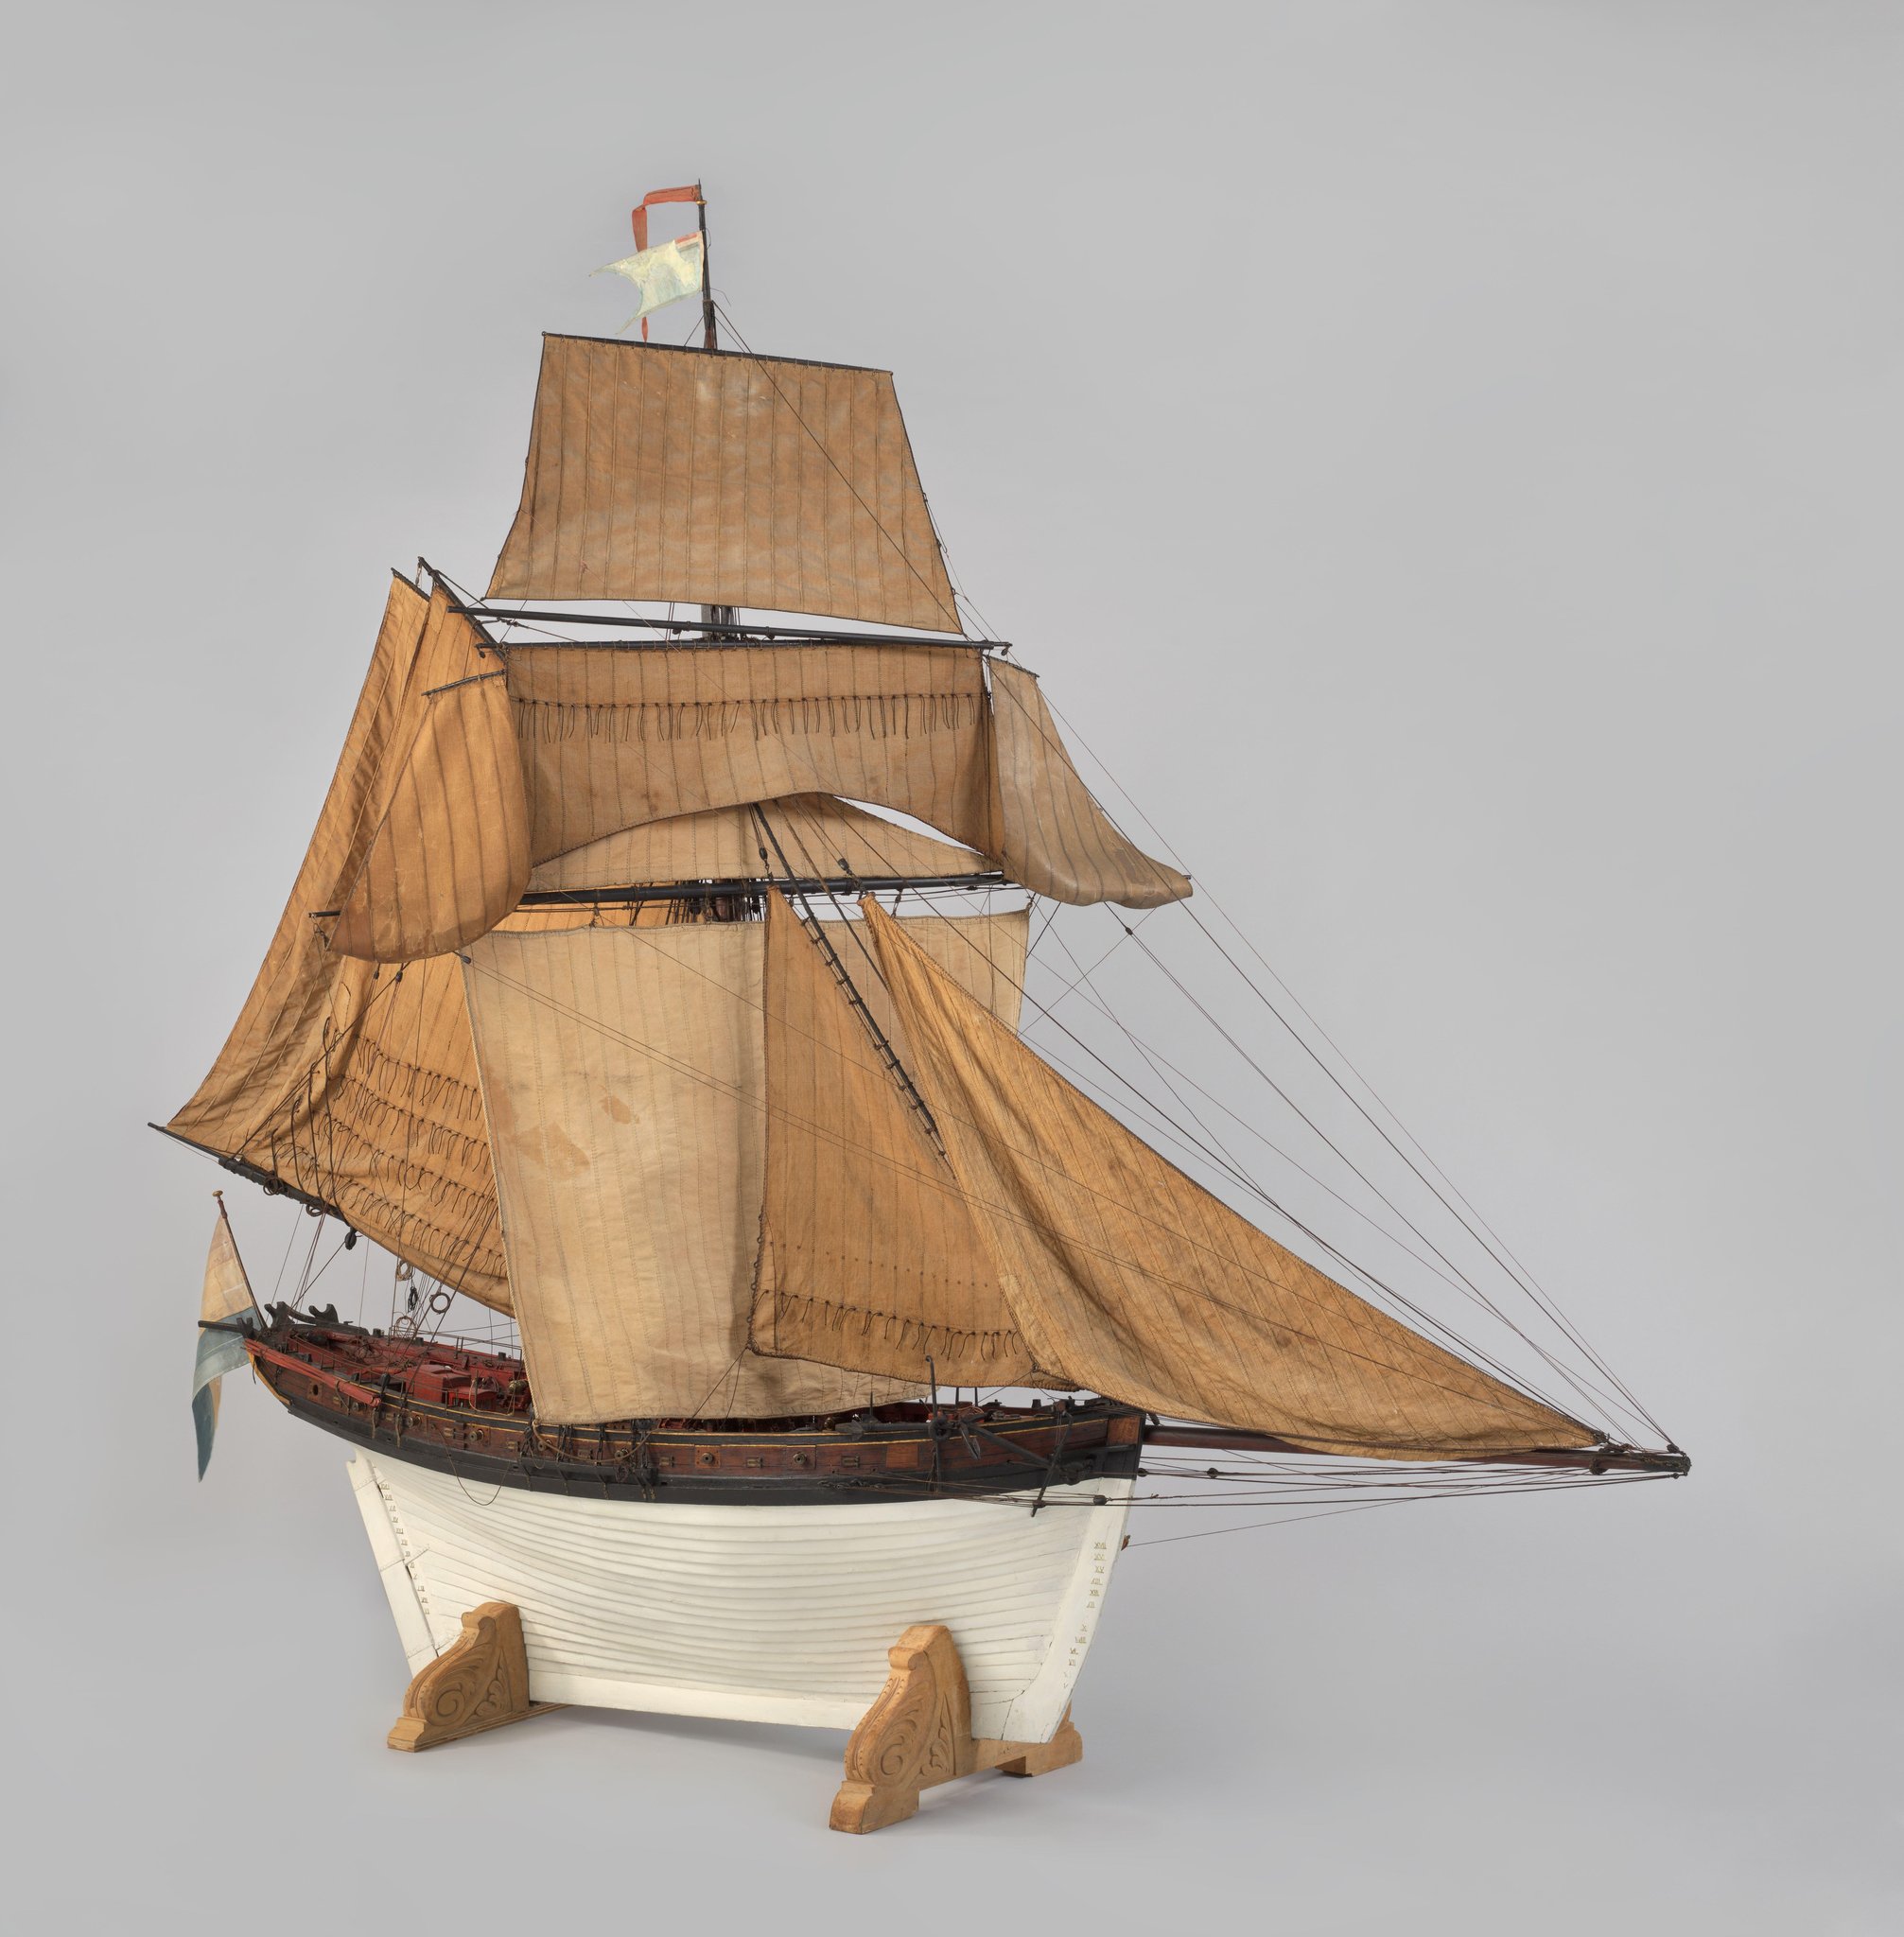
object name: fully rigged model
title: Model of an 18-Gun Cutter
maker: Anonymous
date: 1775-1805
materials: brass, glass, iron, leather, fiber, textile, wood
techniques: polychromy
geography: netherlands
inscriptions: inscription, on the taffrail: ‘VLIEG’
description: Dit model behoorde in 1807 tot de privé-collectie van J.P. Asmus en stond in de modellenzaal op de Marinewerf te Amsterdam. Volgens de beschrijving had het toen nog een sloepje in de davits aan het hek hangen, en een zonnetent over geheel het dek gespannen. Asmus omschreef het model als een voorbeeld van de snelste Engelse kotters.